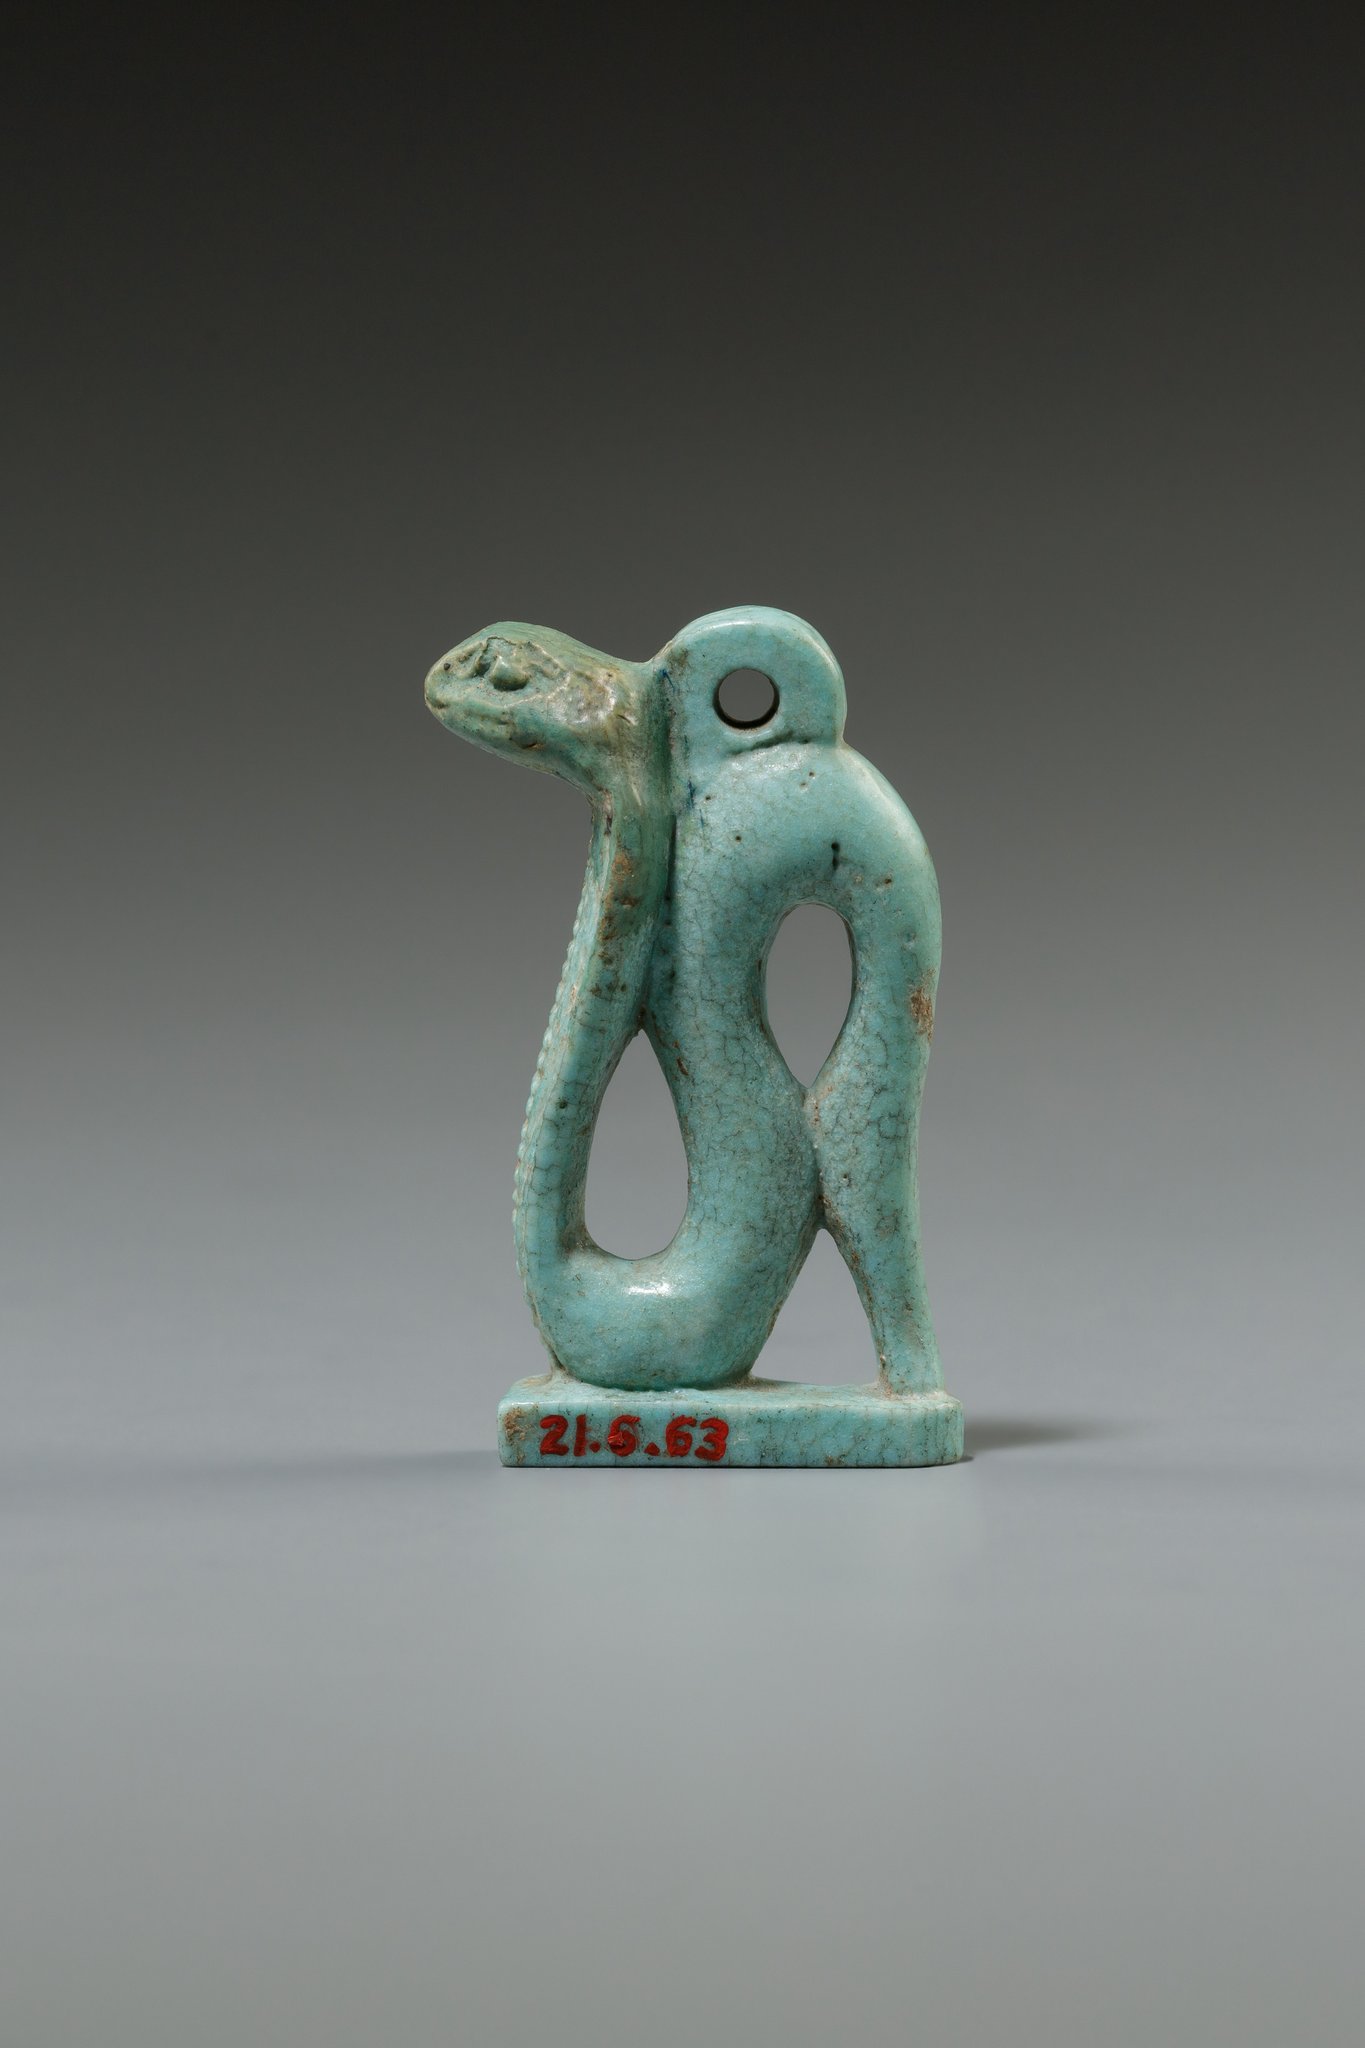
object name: amulet, snake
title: Snake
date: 664-630 BCE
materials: faience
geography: egypt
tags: snakes